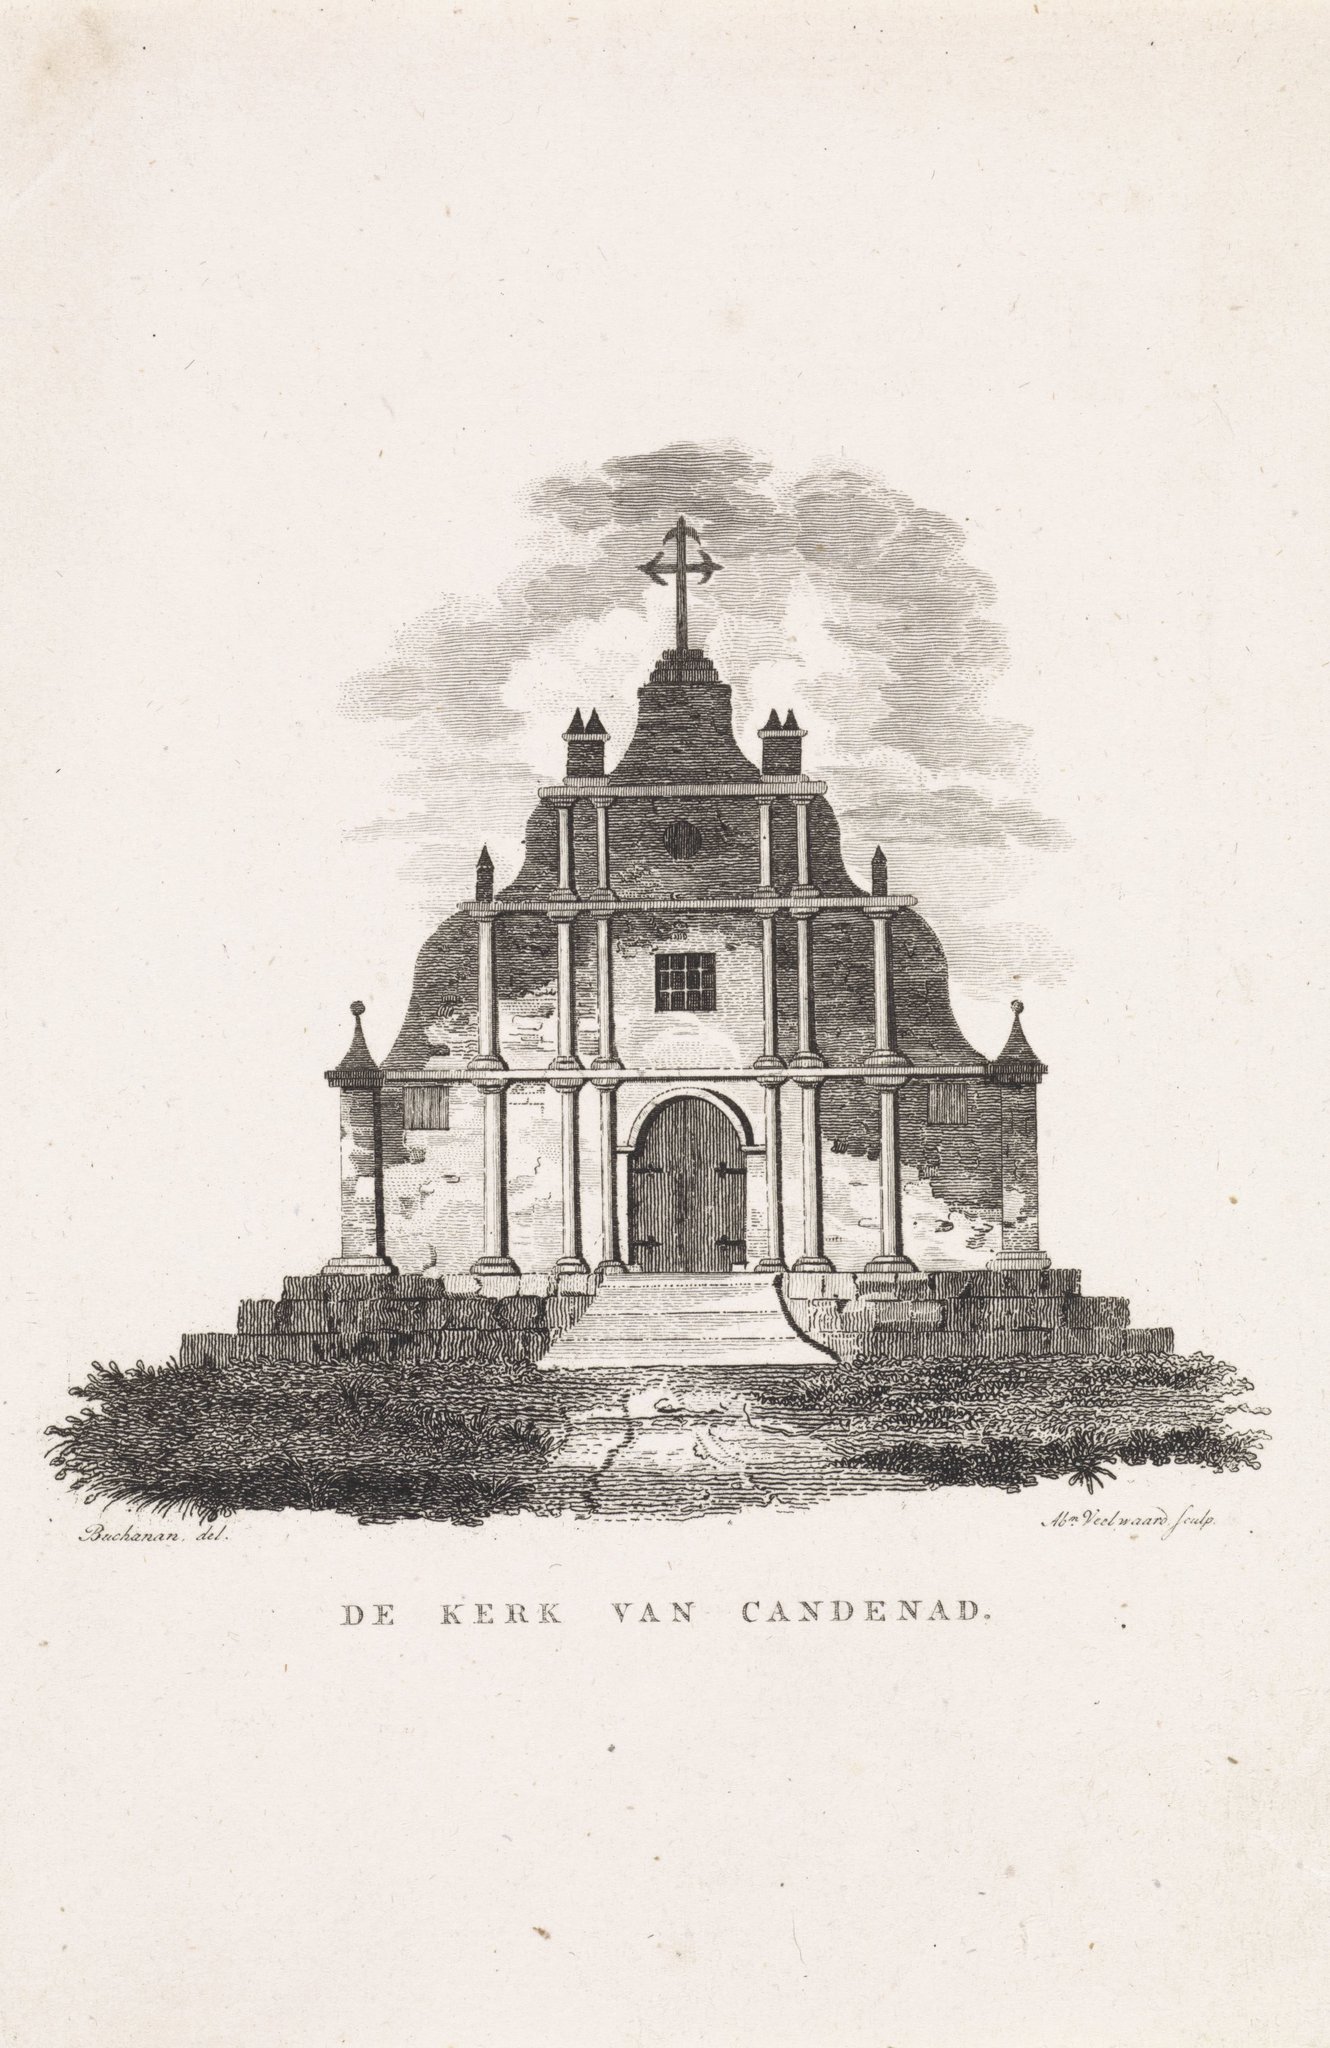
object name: print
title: Kerk te Kandanad, India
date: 1802-1873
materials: paper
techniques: engraving, etching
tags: church (exterior)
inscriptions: collector's mark: Lugt 2228